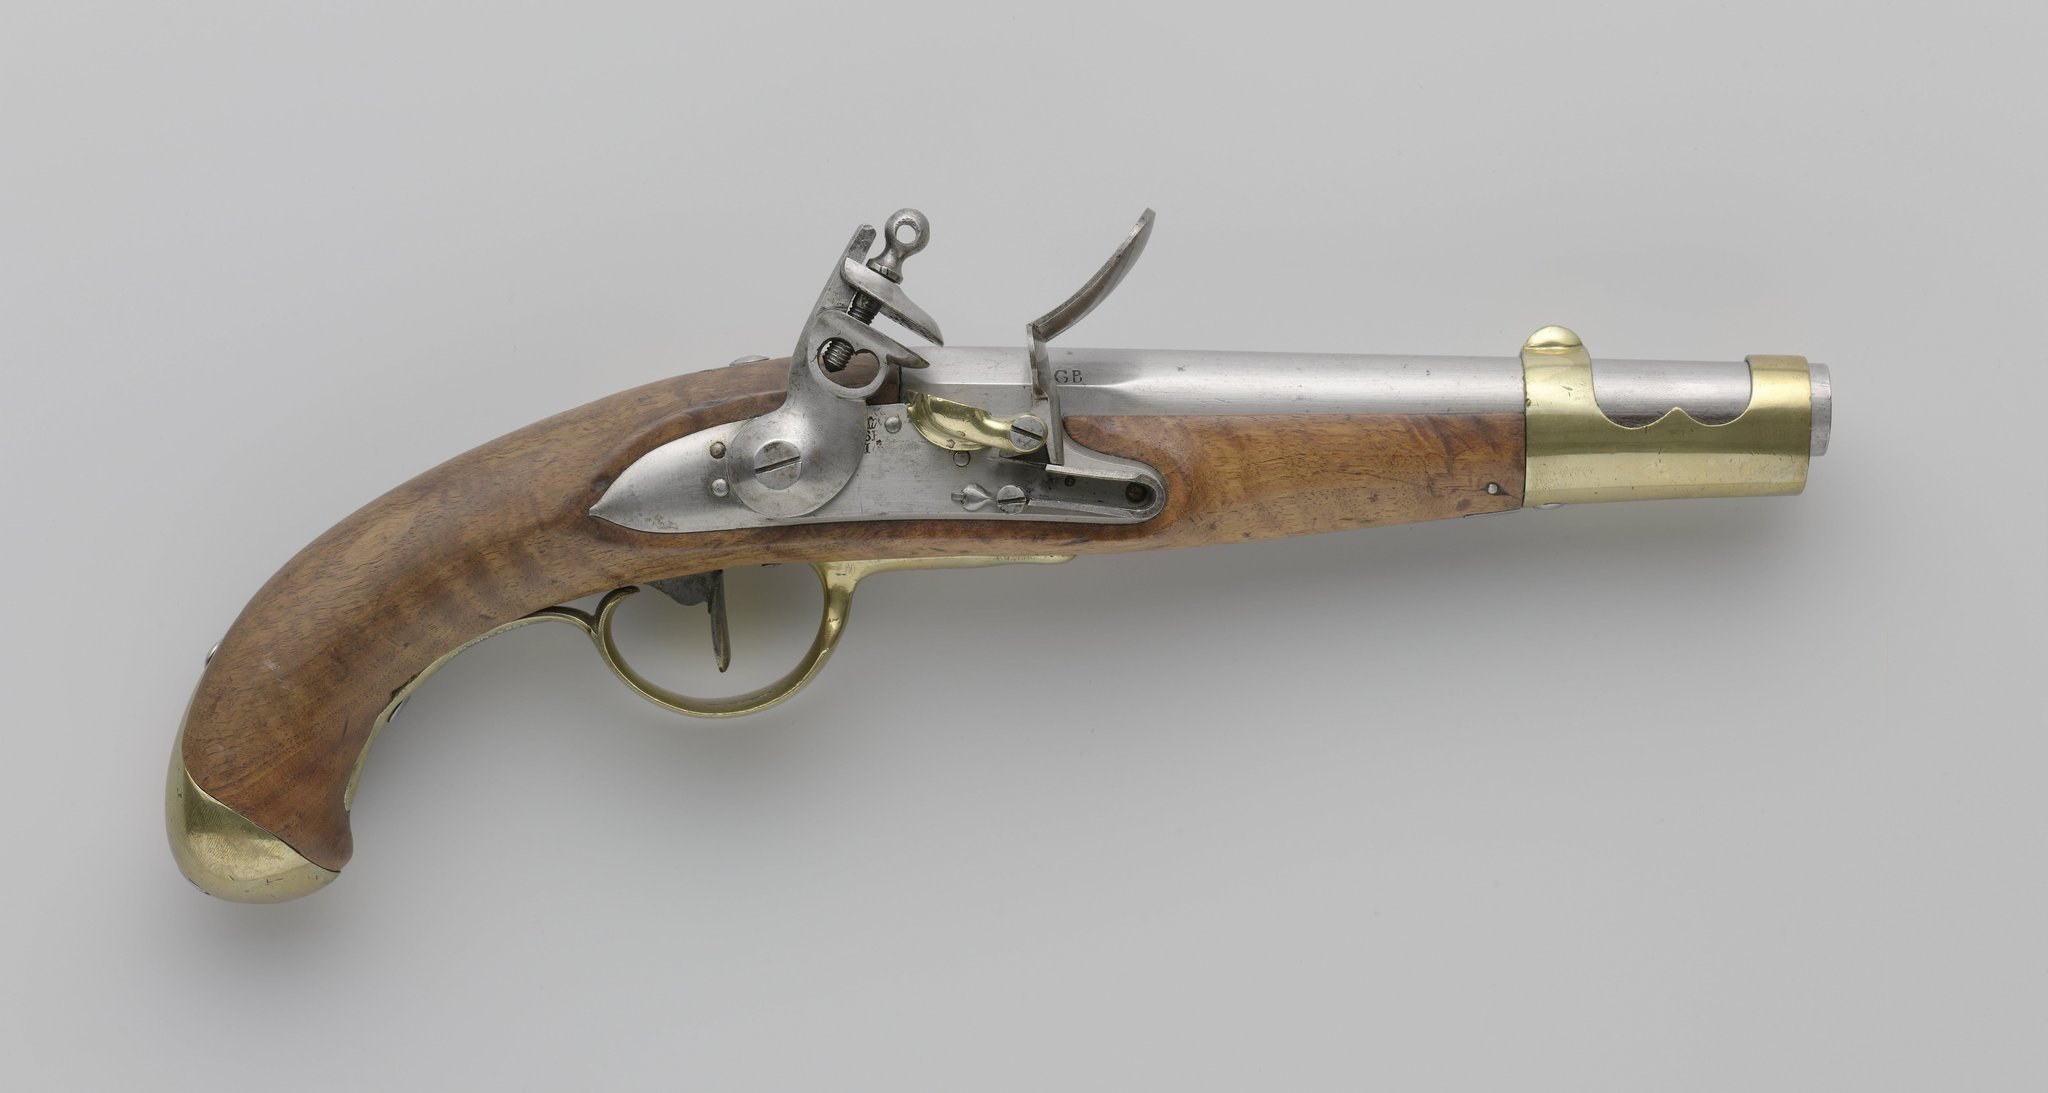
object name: percussion pistol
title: Pistool der lichte cavalerie M 1815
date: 1815-1816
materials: brass, wood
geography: liège